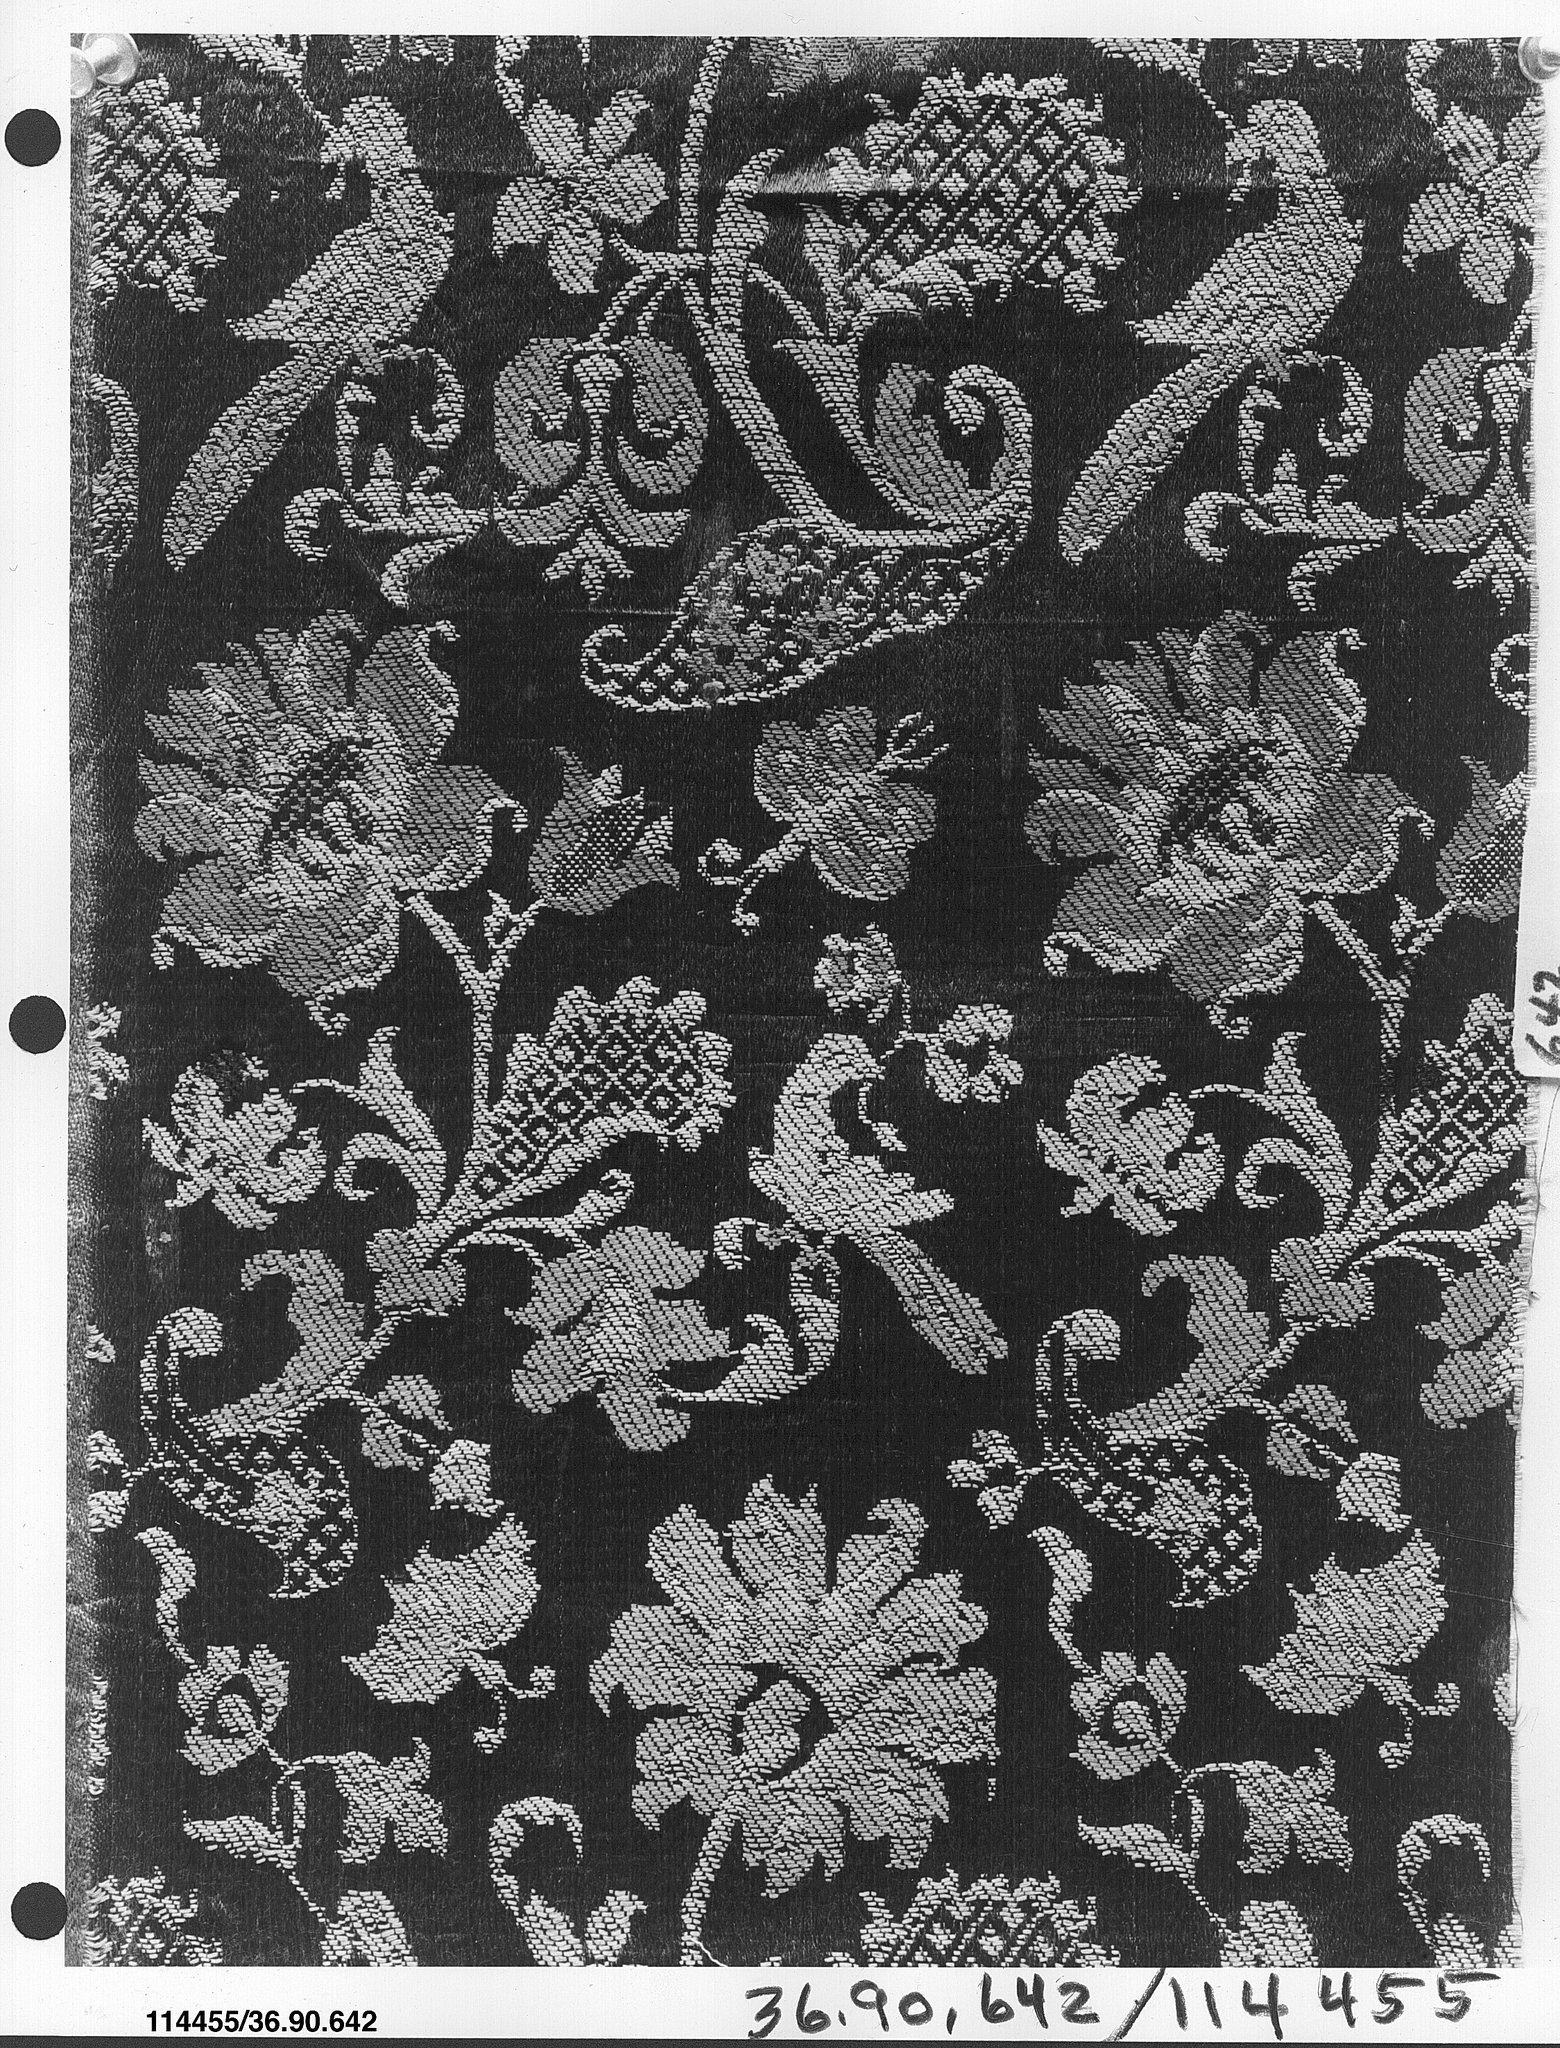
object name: piece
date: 1680-1700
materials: silk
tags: birds,butterflies,flowers